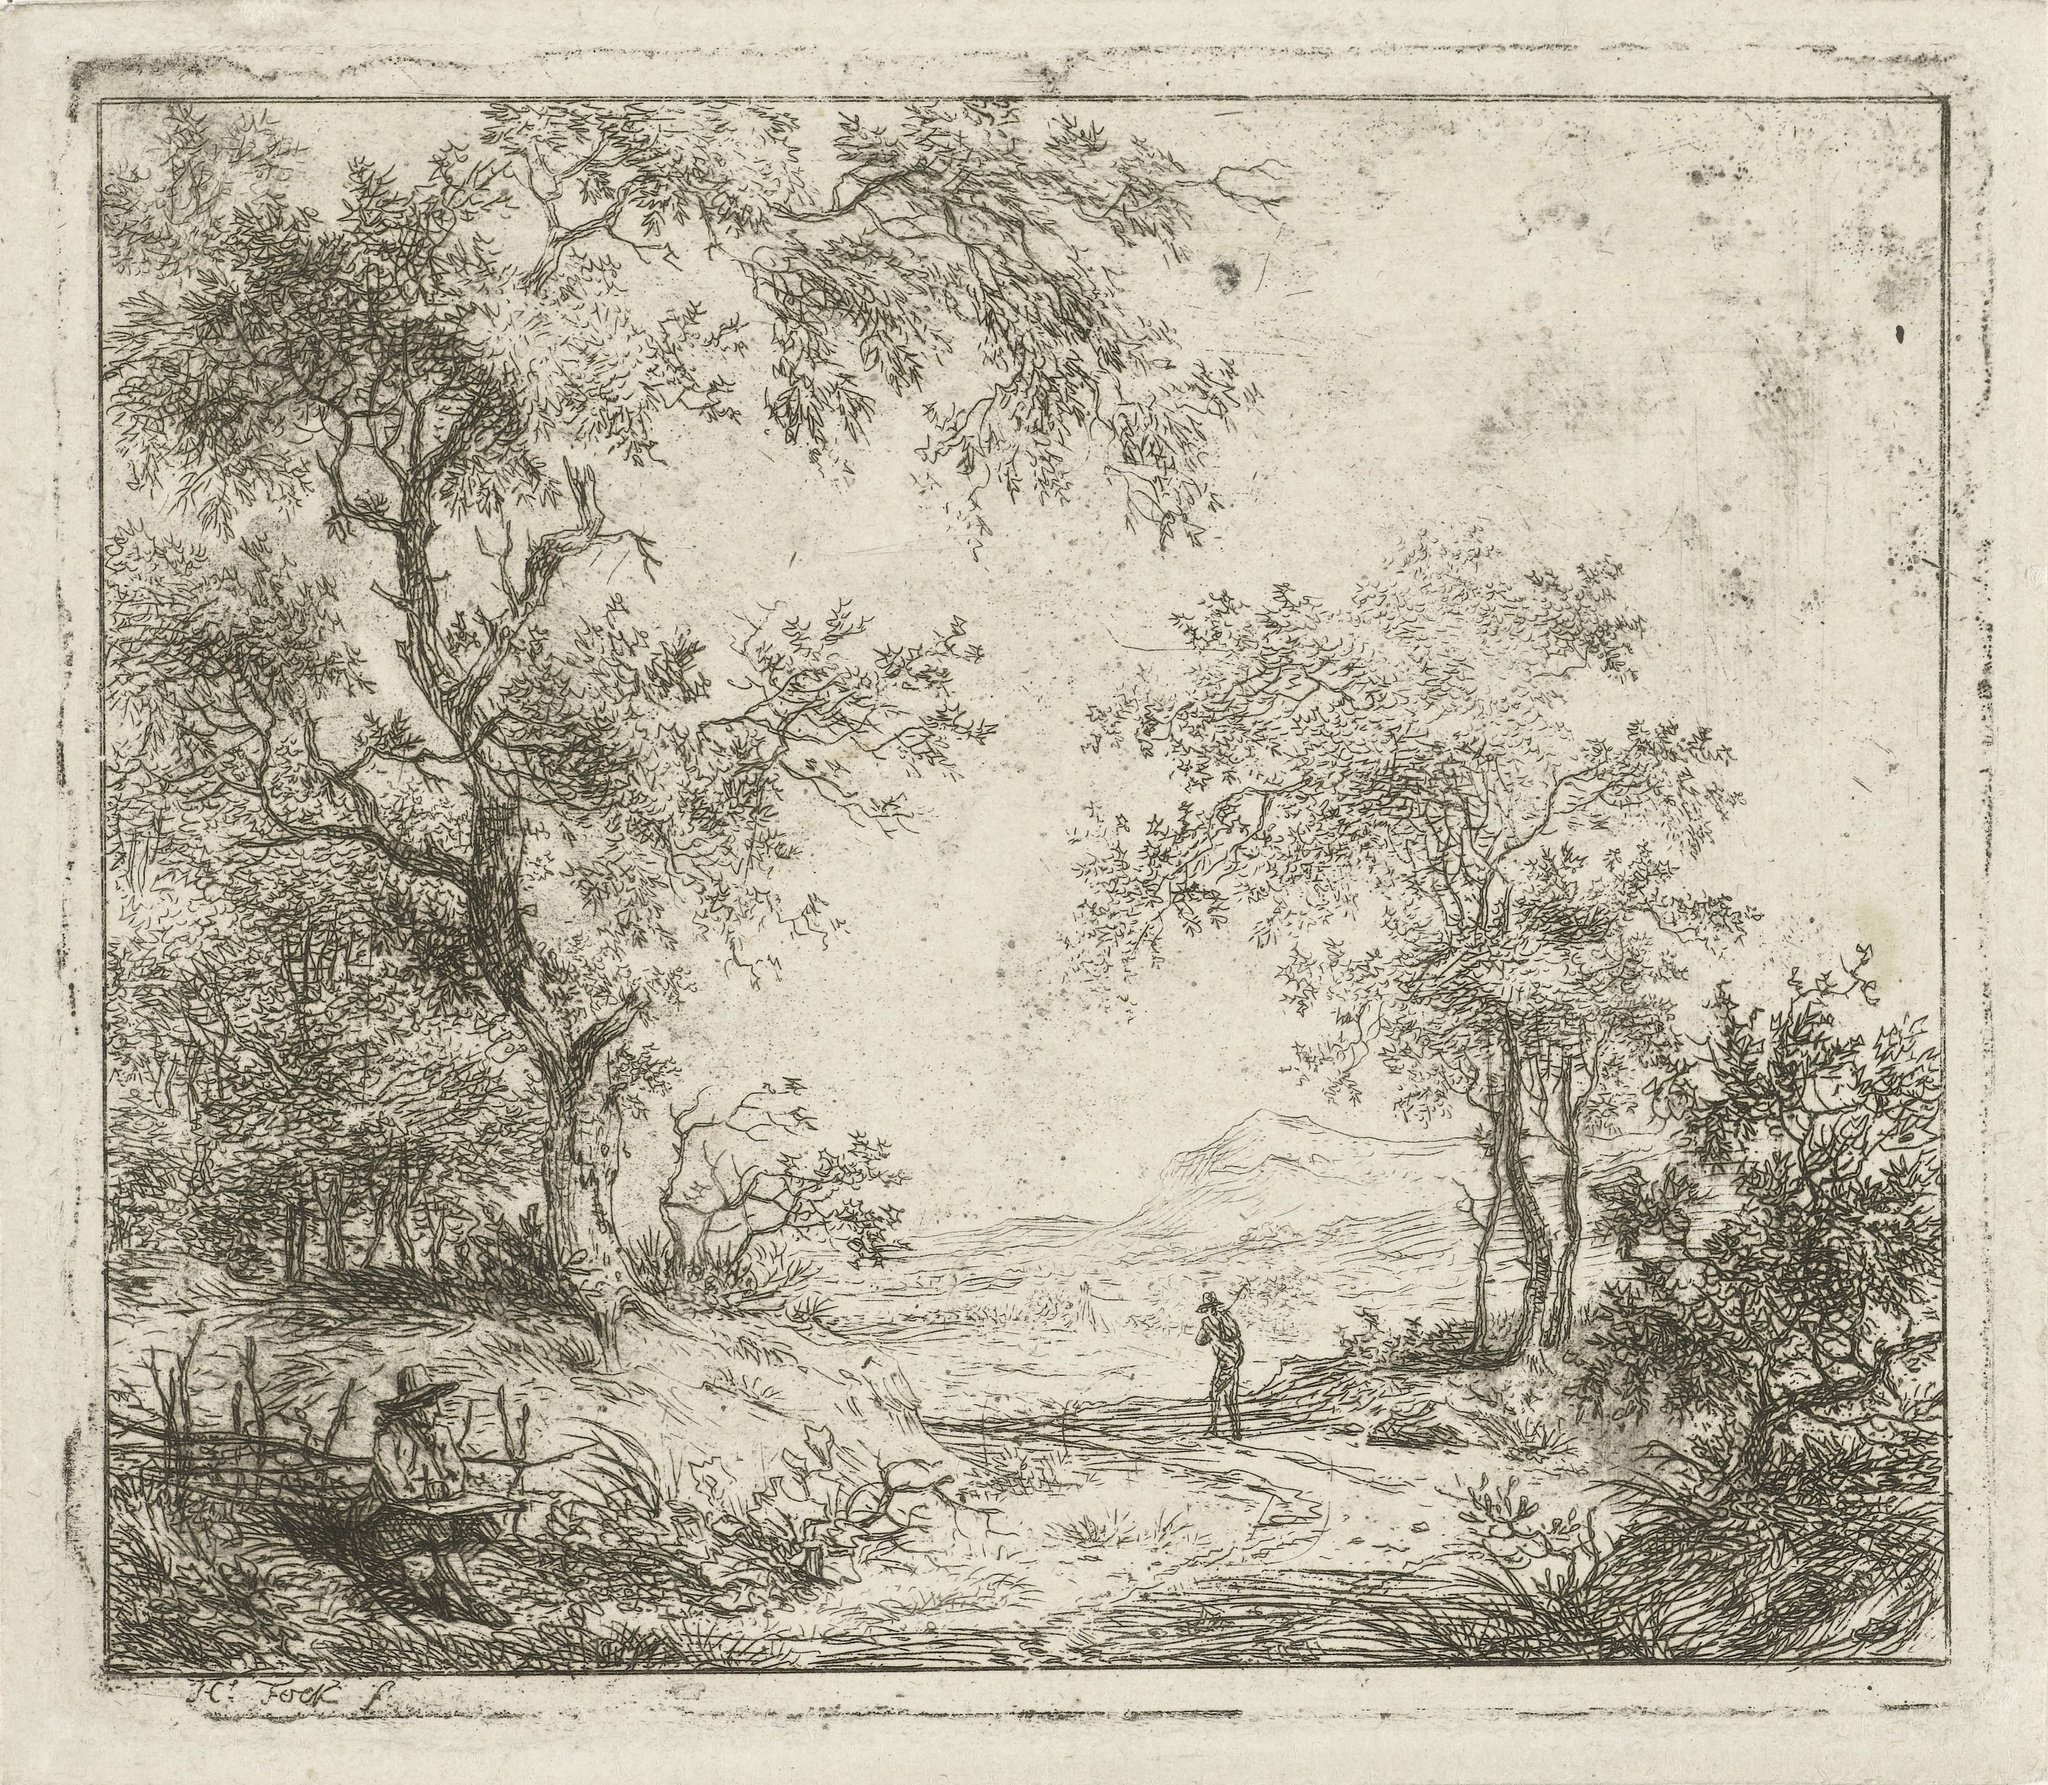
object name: print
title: Zes landschappen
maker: hermanus fock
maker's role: conservator, draughtsman, painter, print maker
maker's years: 1766-1822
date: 1781-1822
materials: paper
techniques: etching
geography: amsterdam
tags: draughtsman at work - cc - out of doors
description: Op een pad met aan weerszijden bomen loopt een wandelaar. Op de voorgrond zit een man met een schetsboek op schoot.